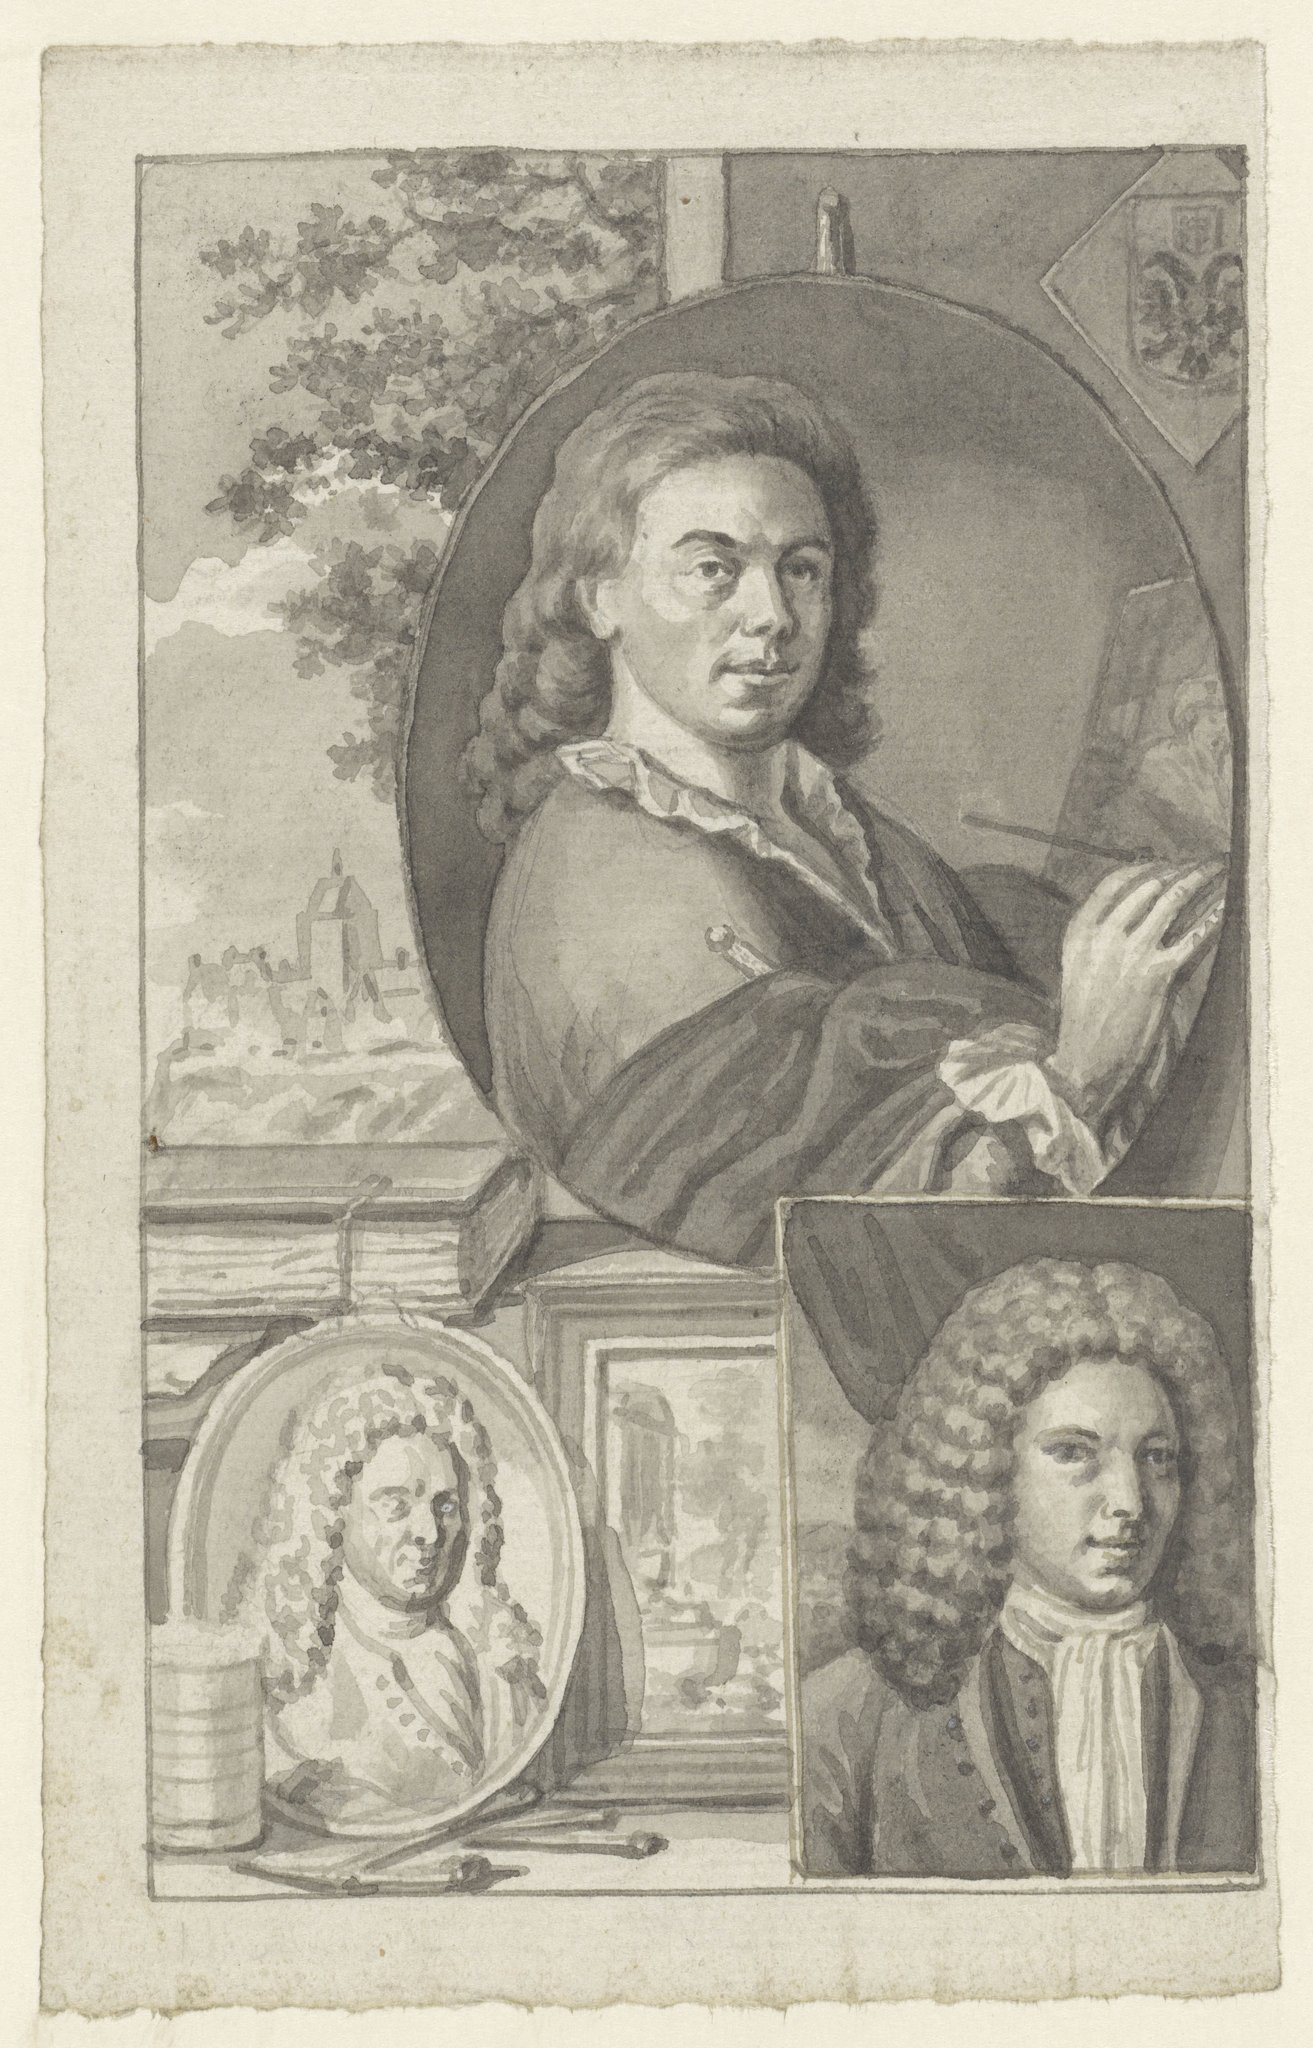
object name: drawing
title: Portretten van Hendrik Soukens, Roukens en Frans van Eynden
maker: roeland van eynden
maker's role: draughtsman, print maker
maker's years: 1747-1819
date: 1757-1819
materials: paper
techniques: brush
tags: painter, draughtsman, hendrik soukens, historical persons, portrait, self-portrait of artist